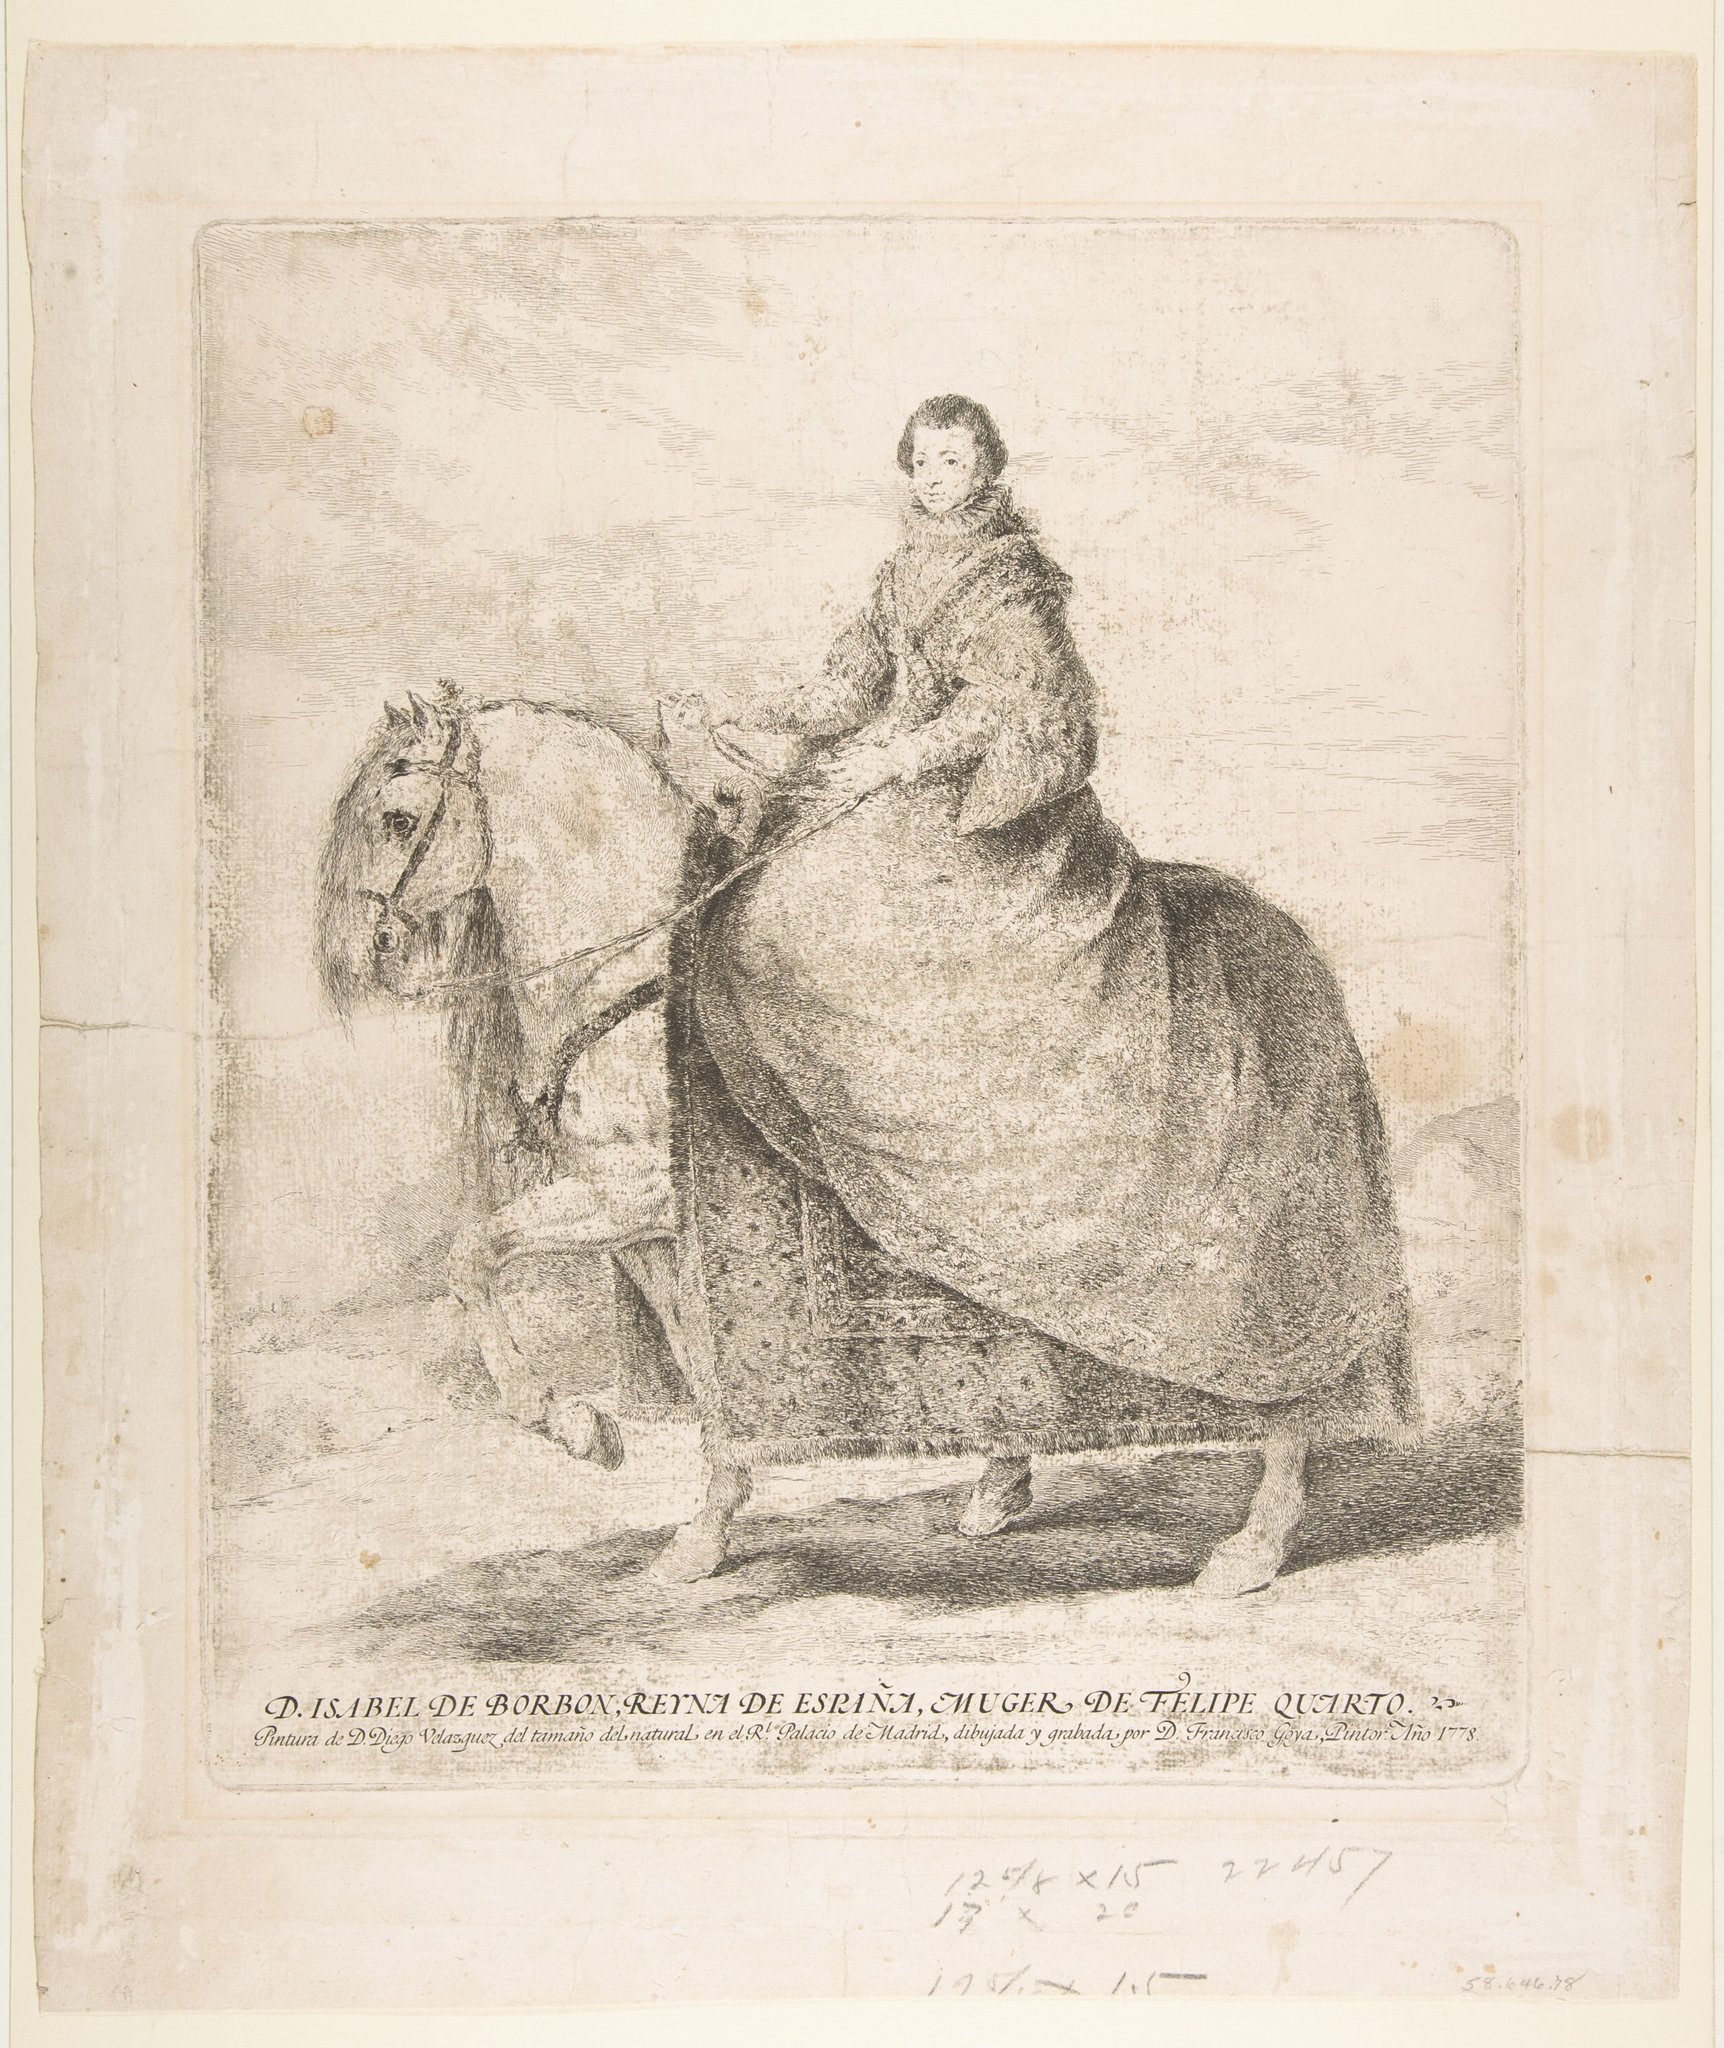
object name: print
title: Isabel of Bourbon, Queen of Spain on horseback, after Veláquez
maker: goya (francisco de goya y lucientes)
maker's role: artist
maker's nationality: spanish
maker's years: 1746-1828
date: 1778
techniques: etching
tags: queens,horses